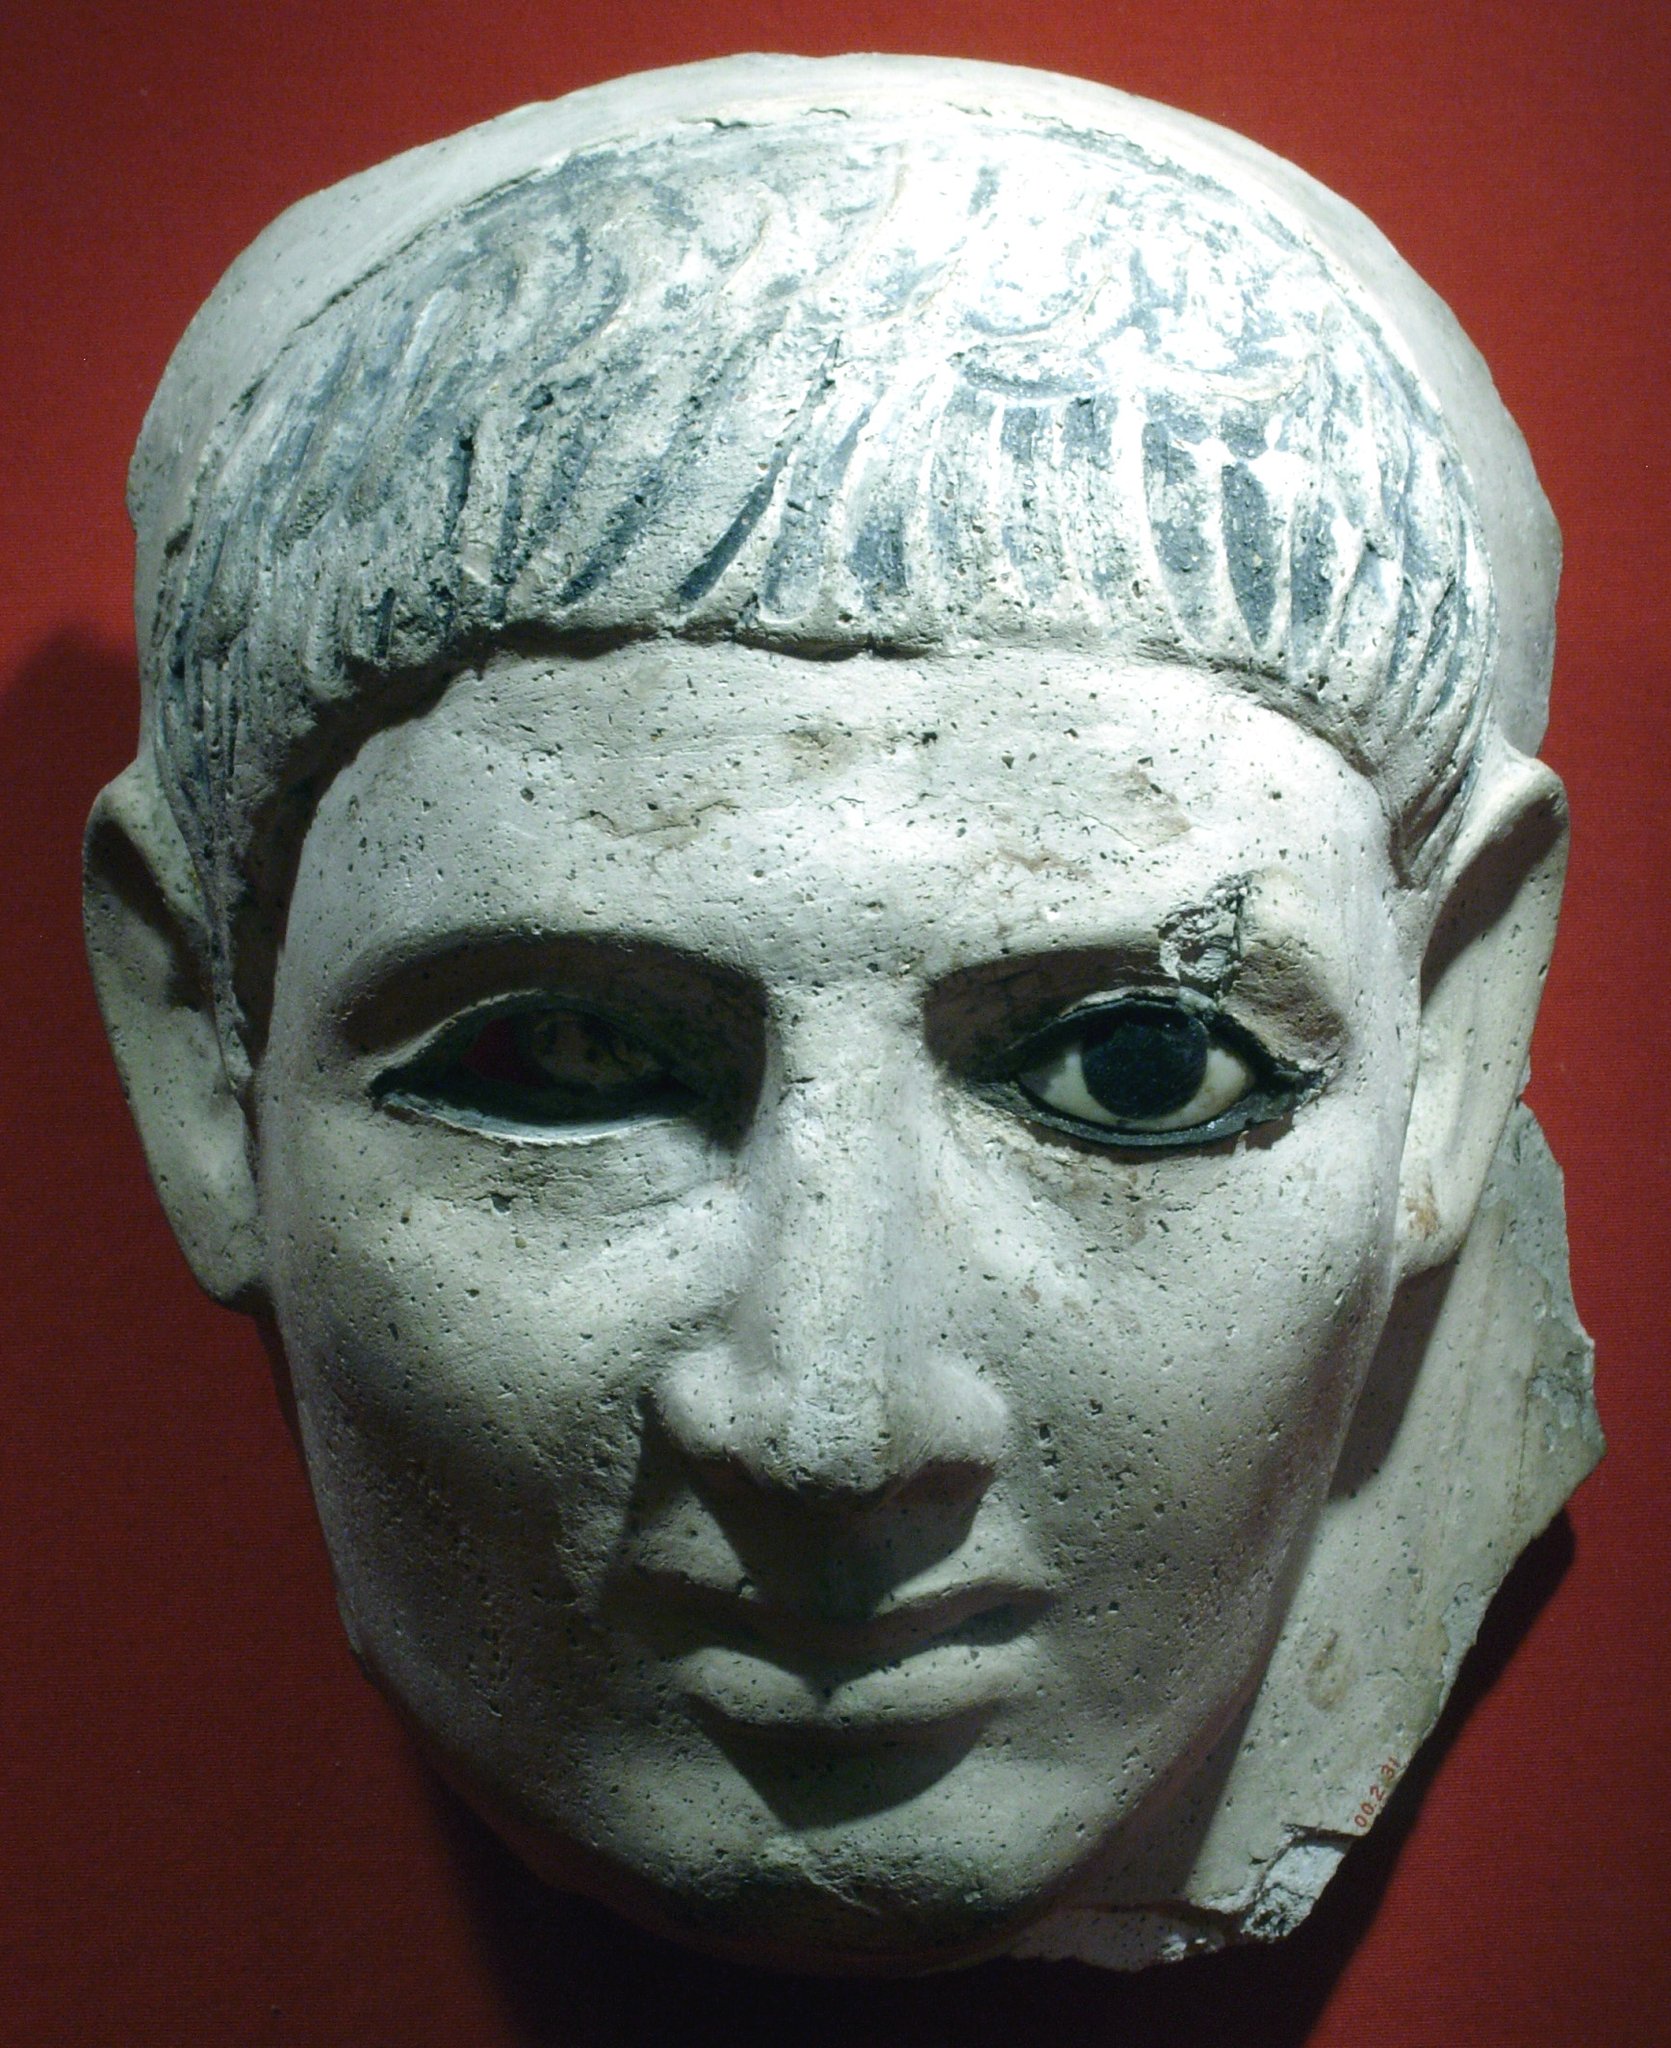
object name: mask, man, striped headcloth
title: Mask of a man who wore a striped headcloth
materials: glass, paint, plaster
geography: egypt